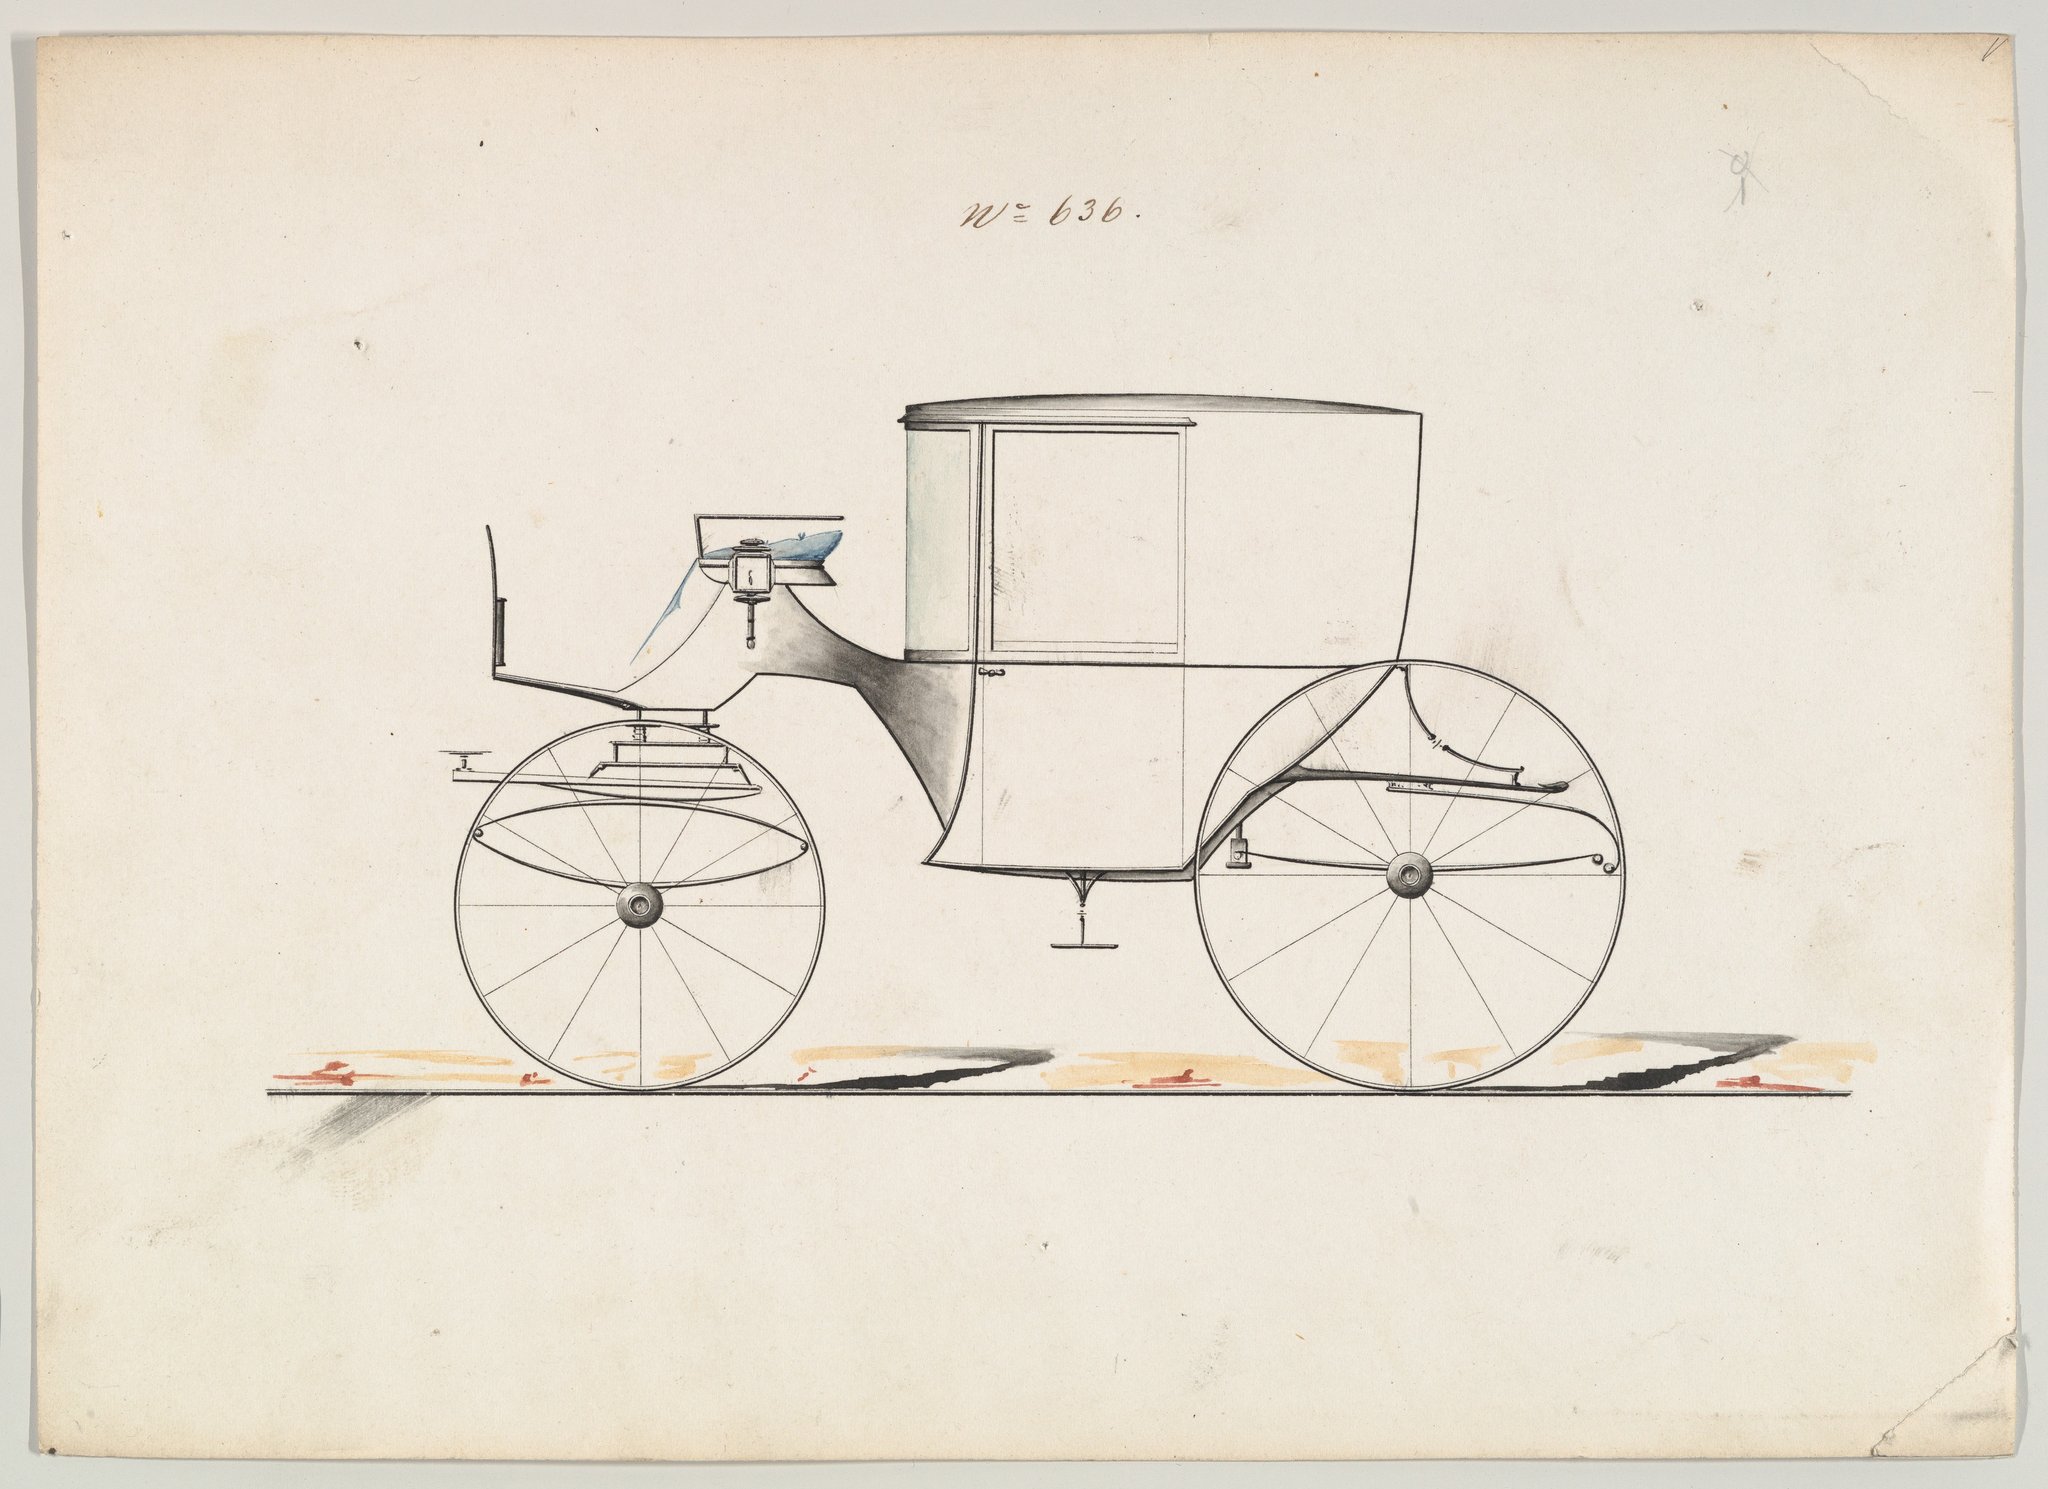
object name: drawing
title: Coupé #636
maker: brewster & co.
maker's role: manufacturer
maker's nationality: american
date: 1850-1870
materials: watercolor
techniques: pen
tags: carriages